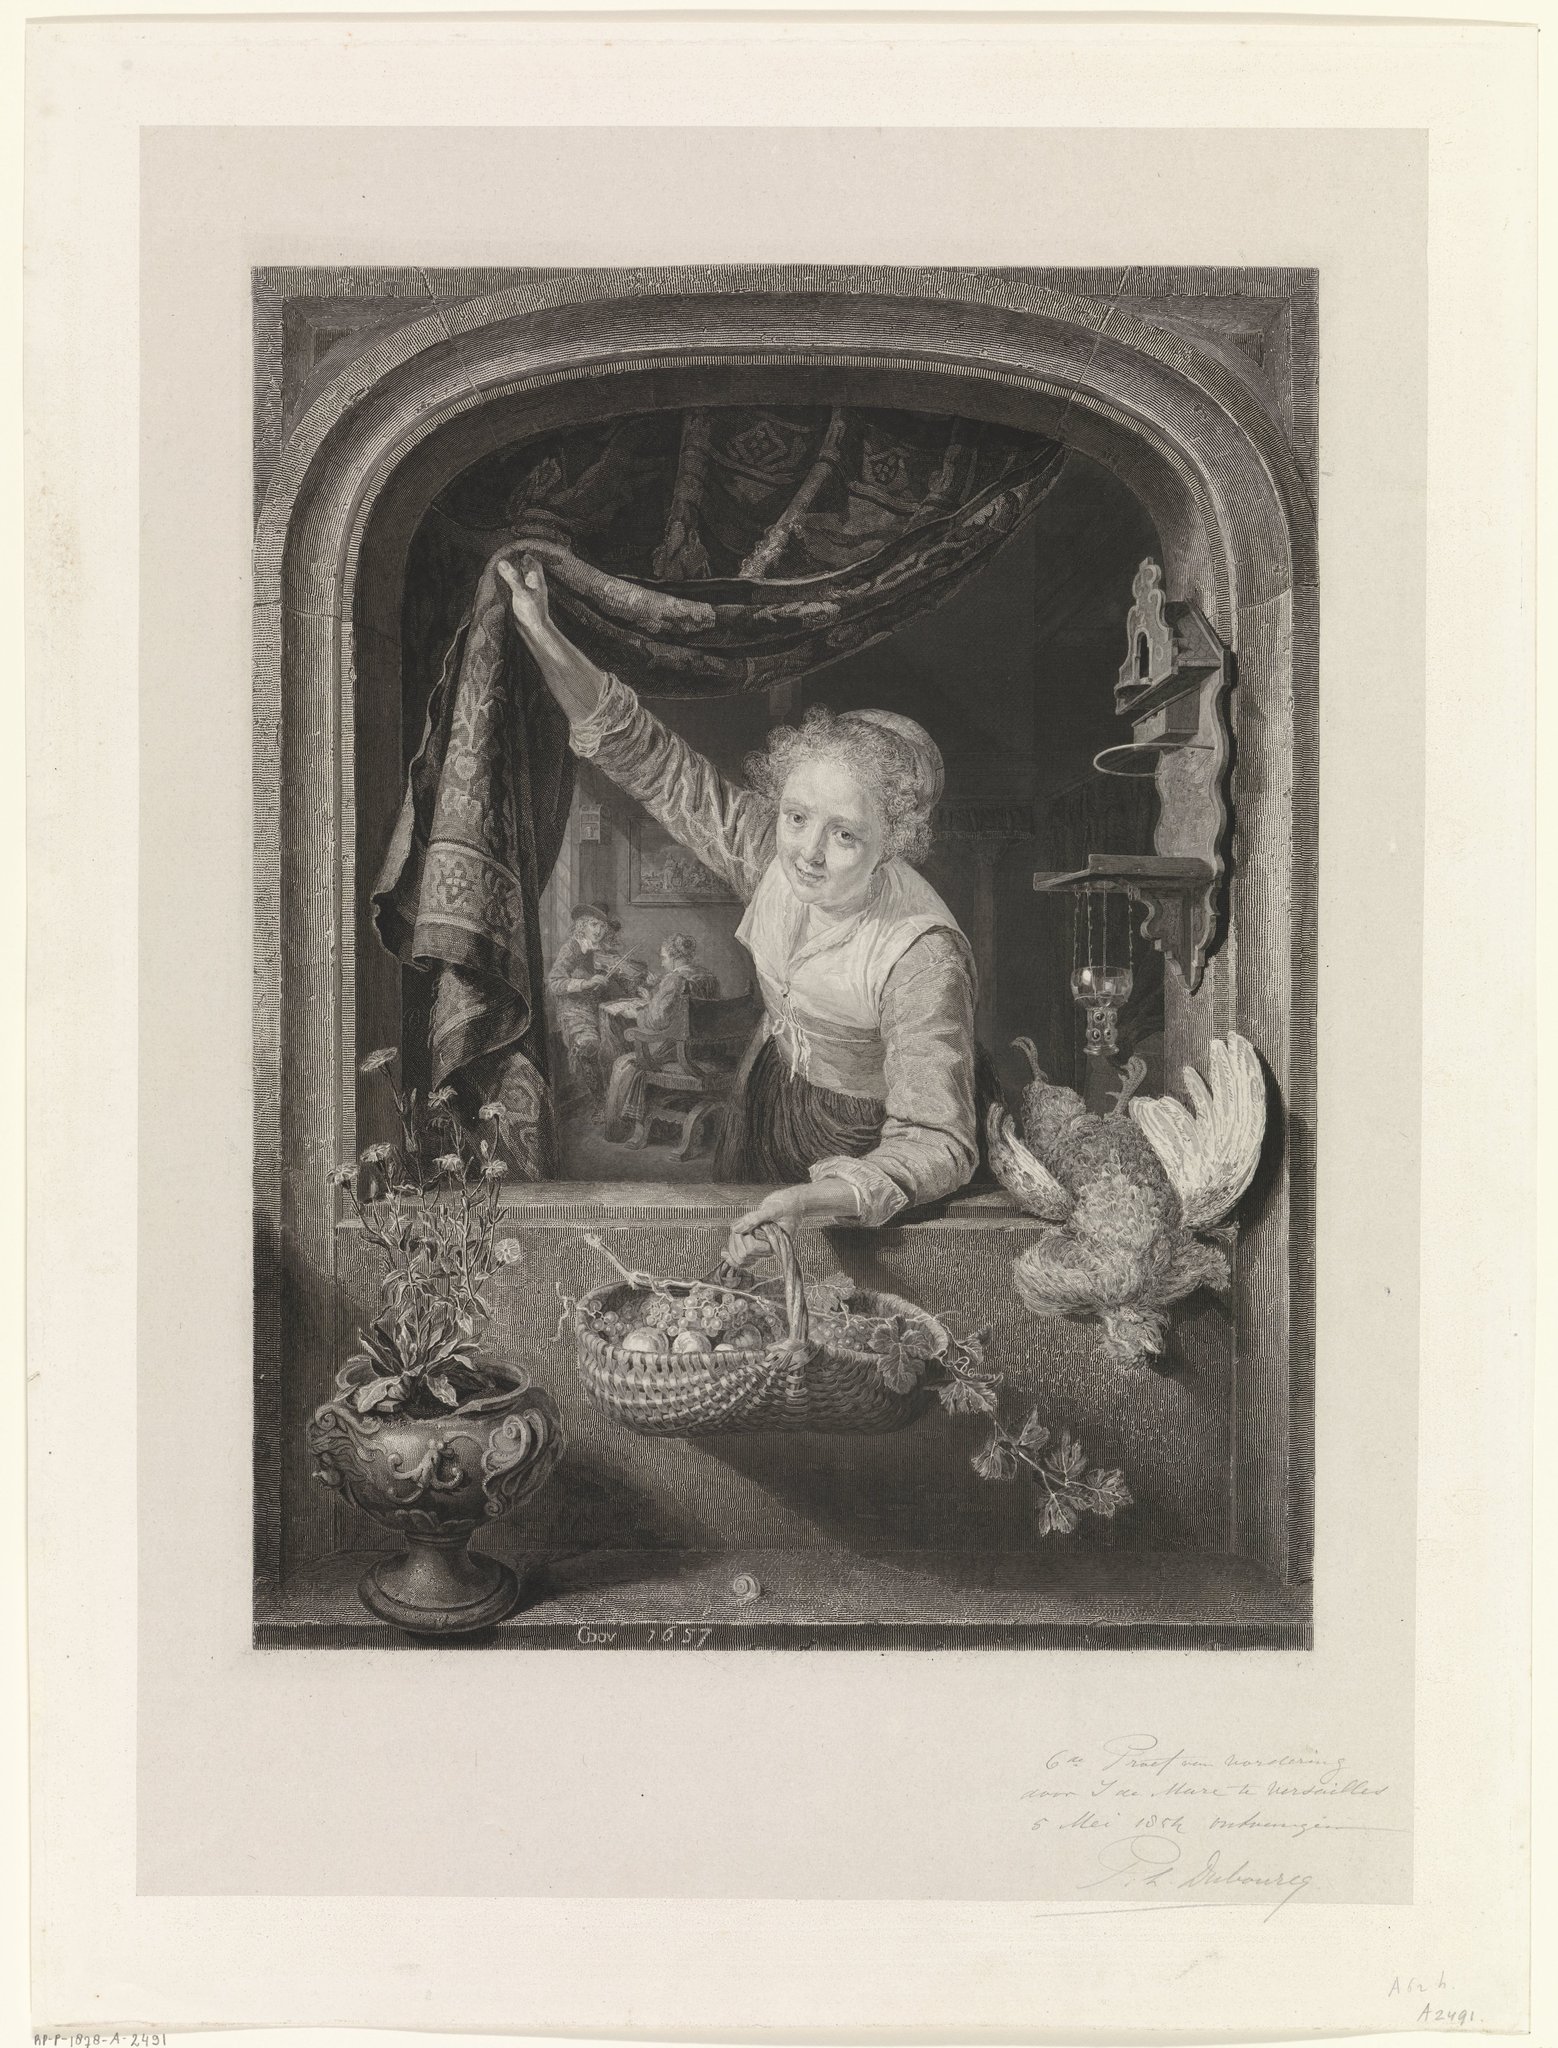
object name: print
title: Vrouw met mand met vruchten in de hand bij het raam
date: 1854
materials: paper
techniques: engraving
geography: versailles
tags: nesting-box, instrumental and vocal music together, human figure at (open) window, seen from outside, attributes of aesculapius: cock, maid ~ house personnel, shop-window, show-window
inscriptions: collector's mark: Lugt 2228, inscription: ‘6de Proef van vordering / door J de Mare te Versailles / 5 Mei 1854 ontvangen / Ph Duboureg’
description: Een jonge vrouw met een mand met vruchten in de hand hangt uit een venster. Ze houdt het gordijn opzij zodat het interieur achter haar zichtbaar is. In het vertrek zijn een man en een vrouw aan het musiceren. In de vensterbank hangt een vogelhuis, ligt een dode haan en staat een vaas met bloemen.